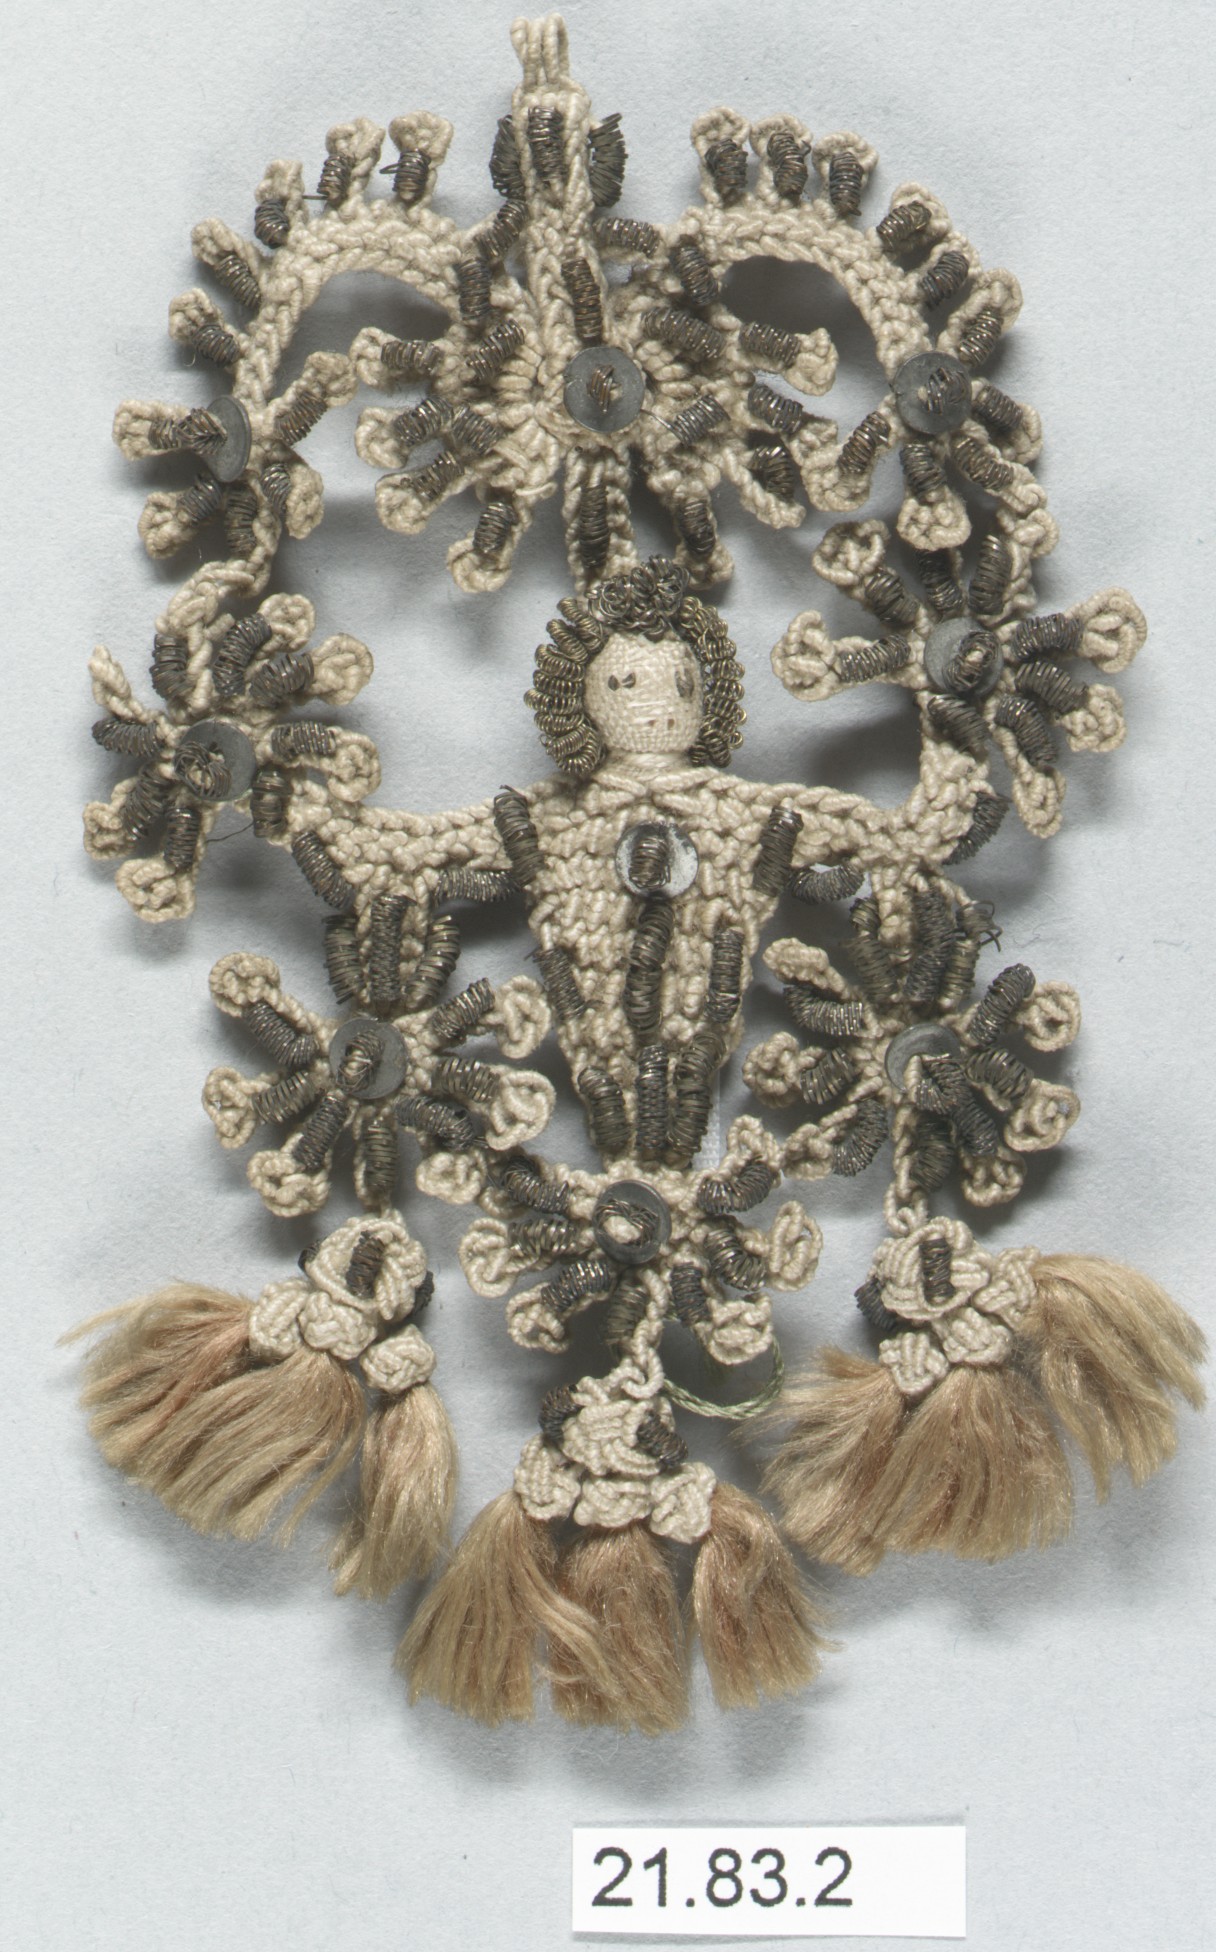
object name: tassel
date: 1601-1700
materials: metal thread